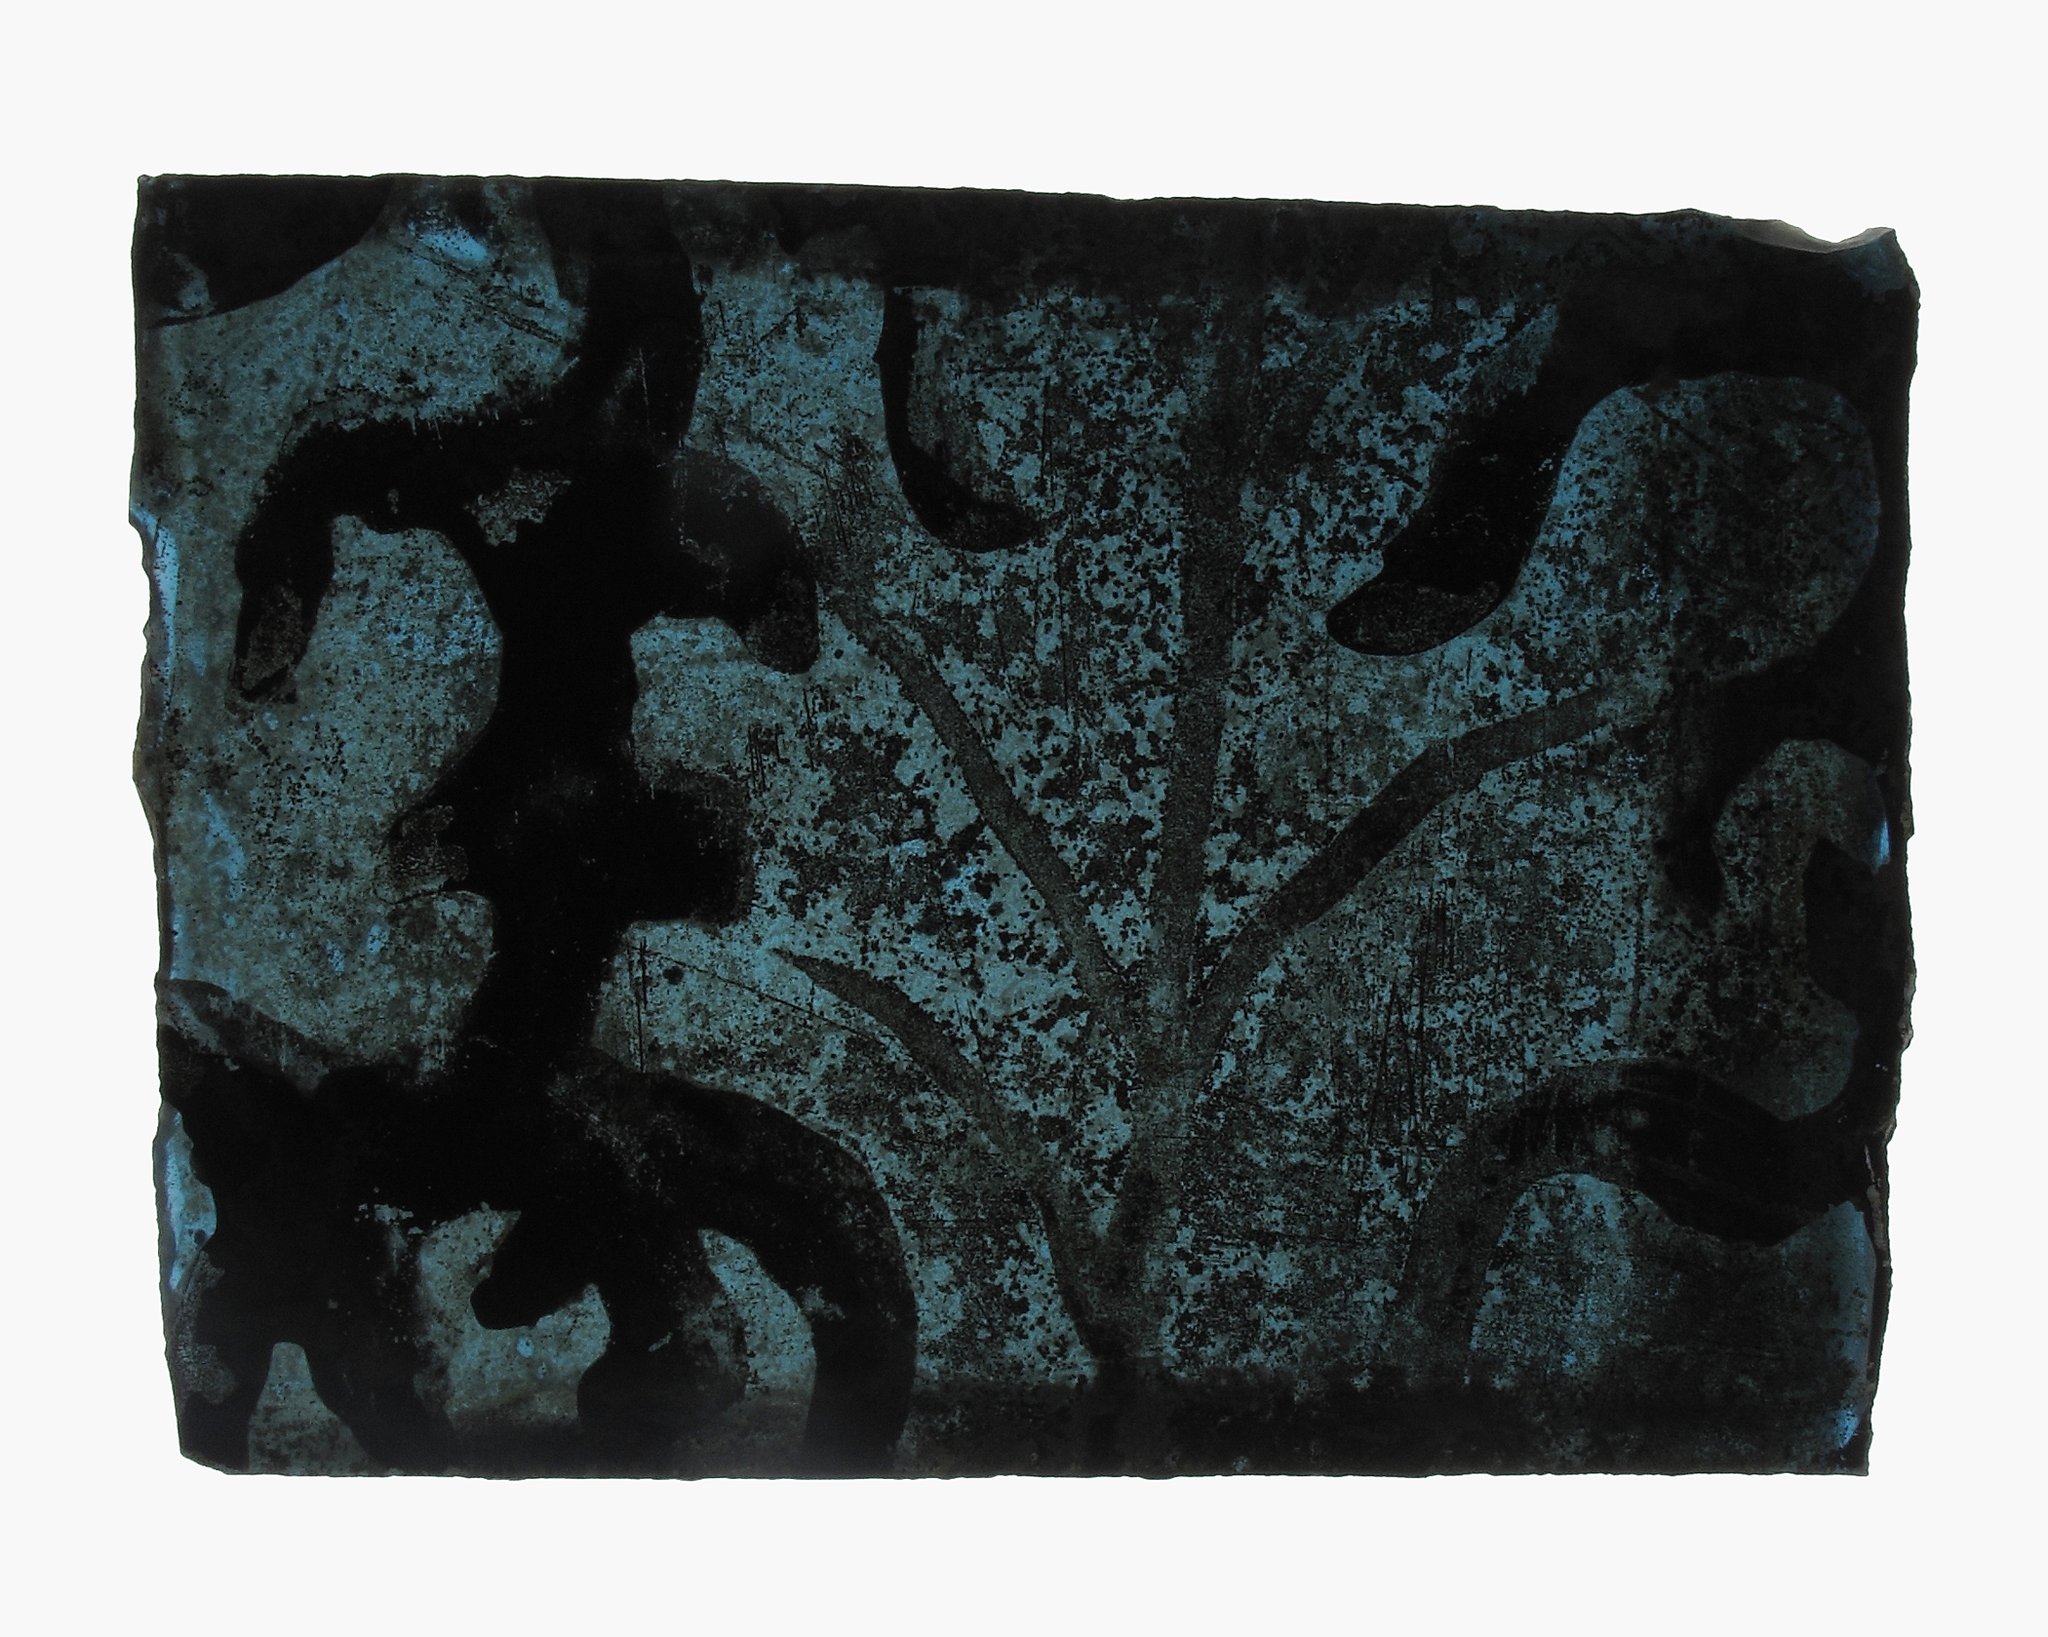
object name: fragment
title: Glass Fragment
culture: french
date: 1301-1400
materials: glass, metal